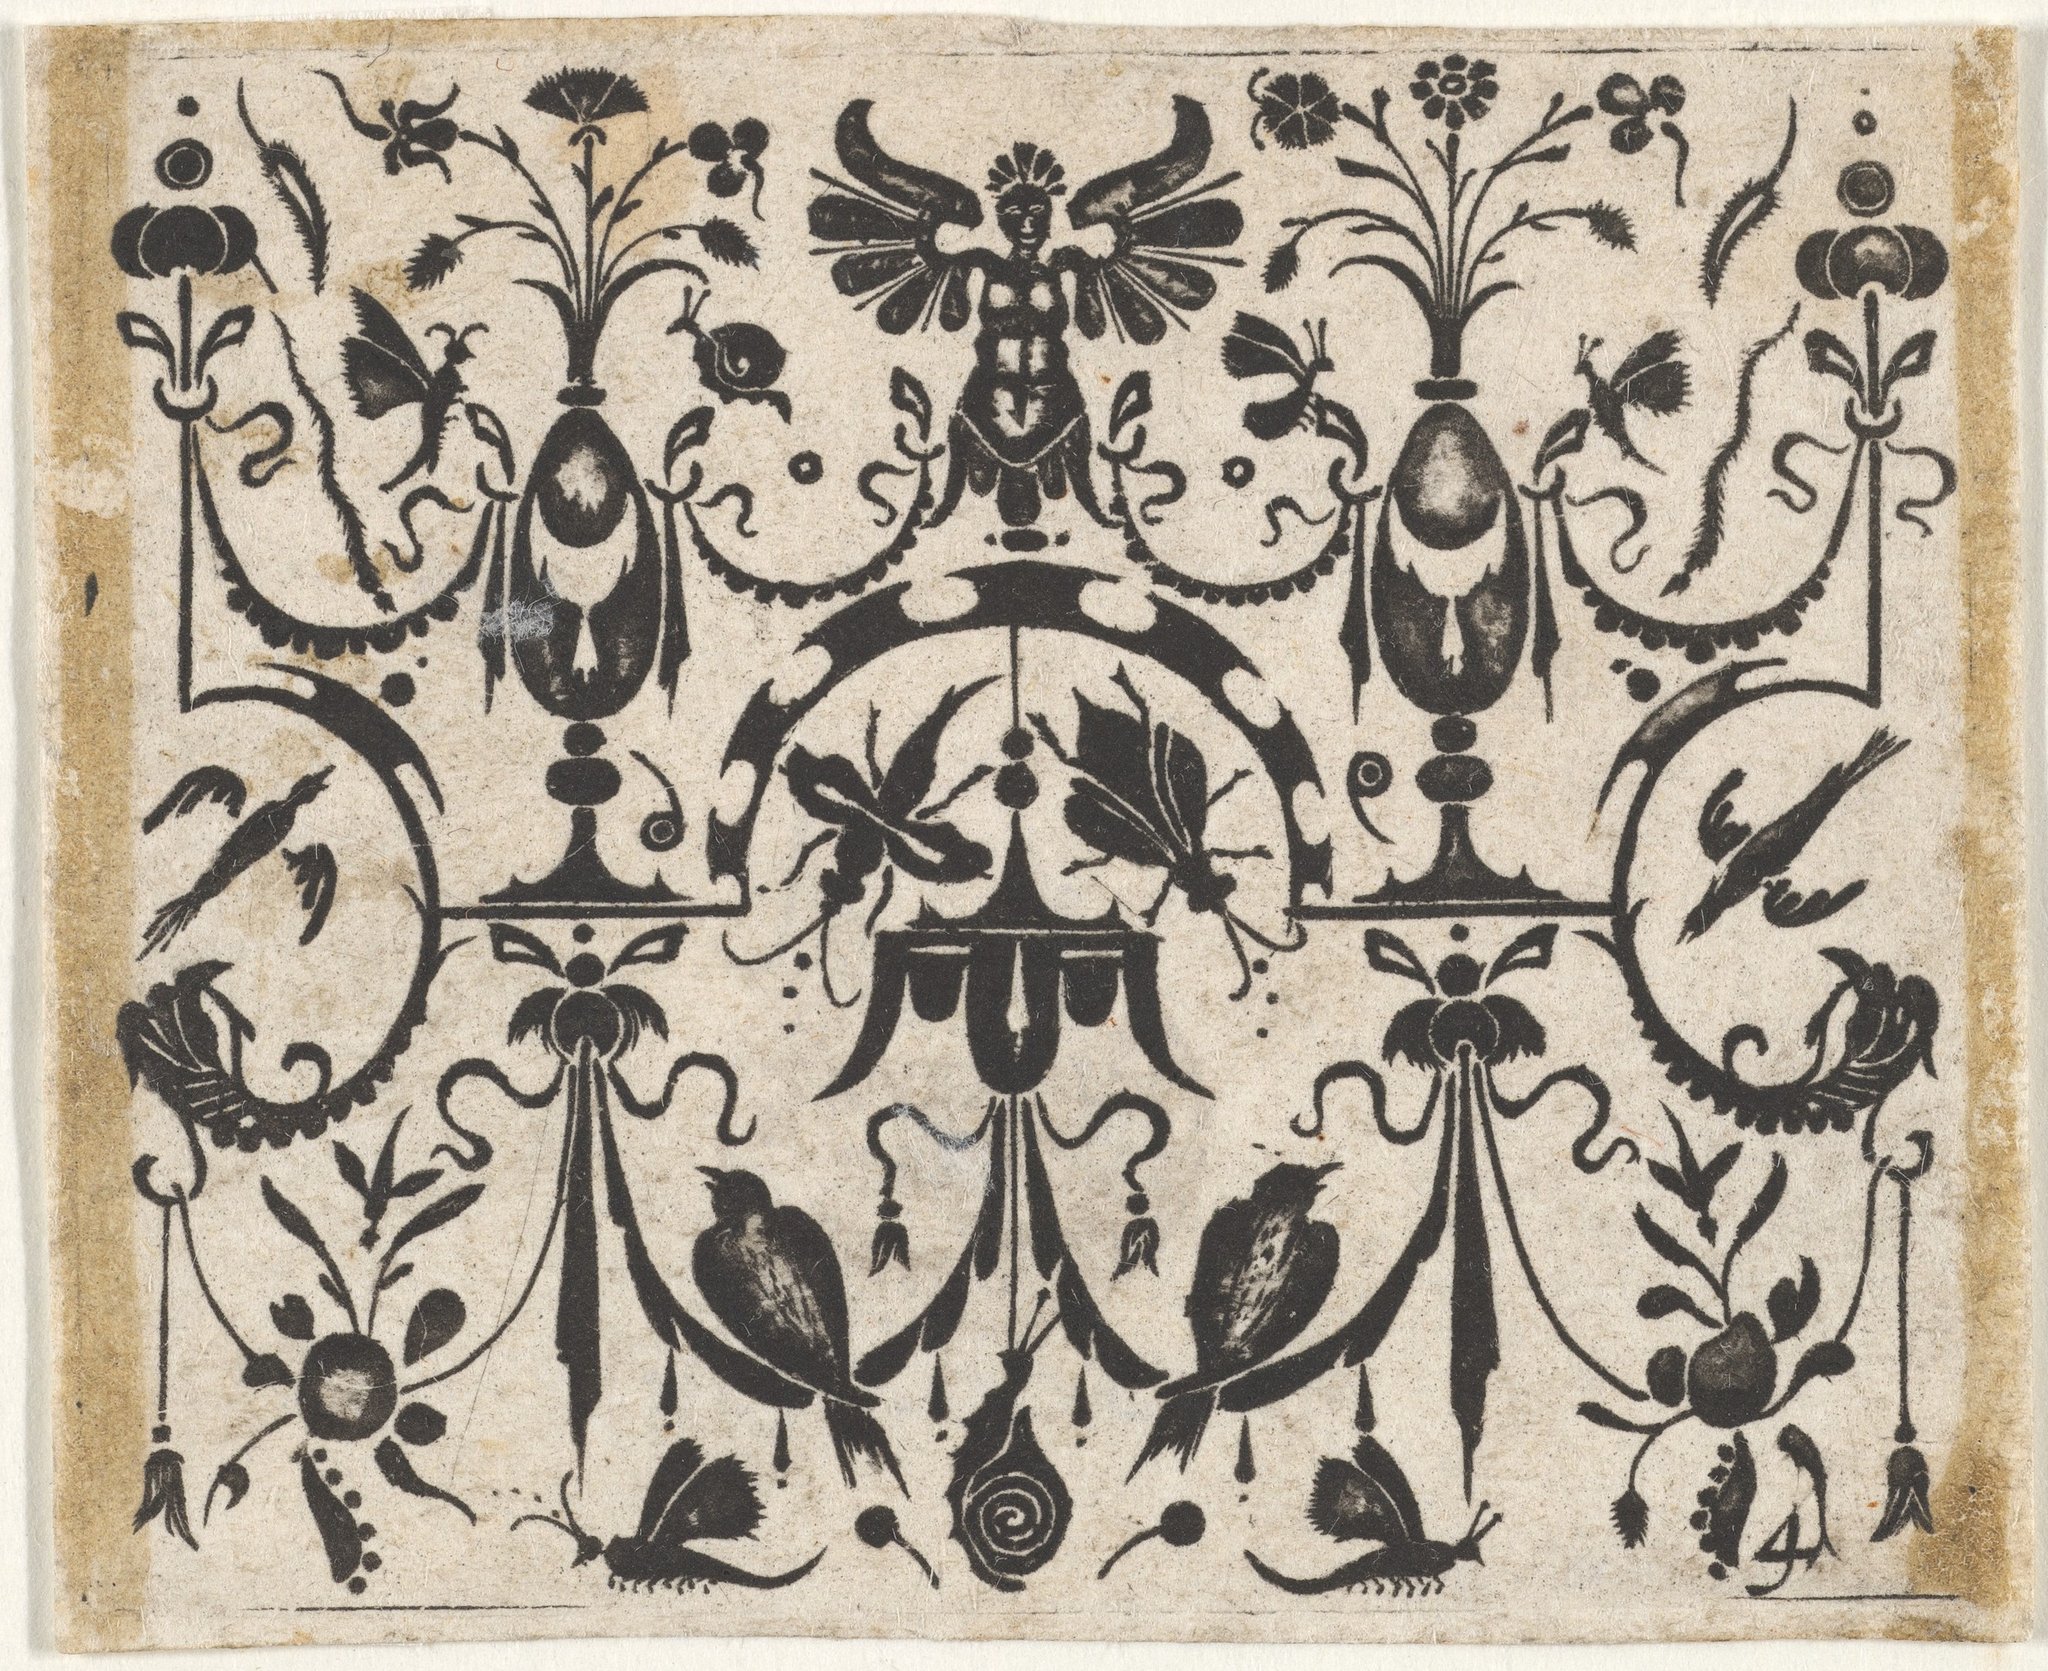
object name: print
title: Blackwork Print with a Symmetric Grotesque Pattern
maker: claes jansz. visscher (ii)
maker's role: artist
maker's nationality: dutch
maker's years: 1586-1652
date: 1620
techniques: embroidery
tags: birds,insects